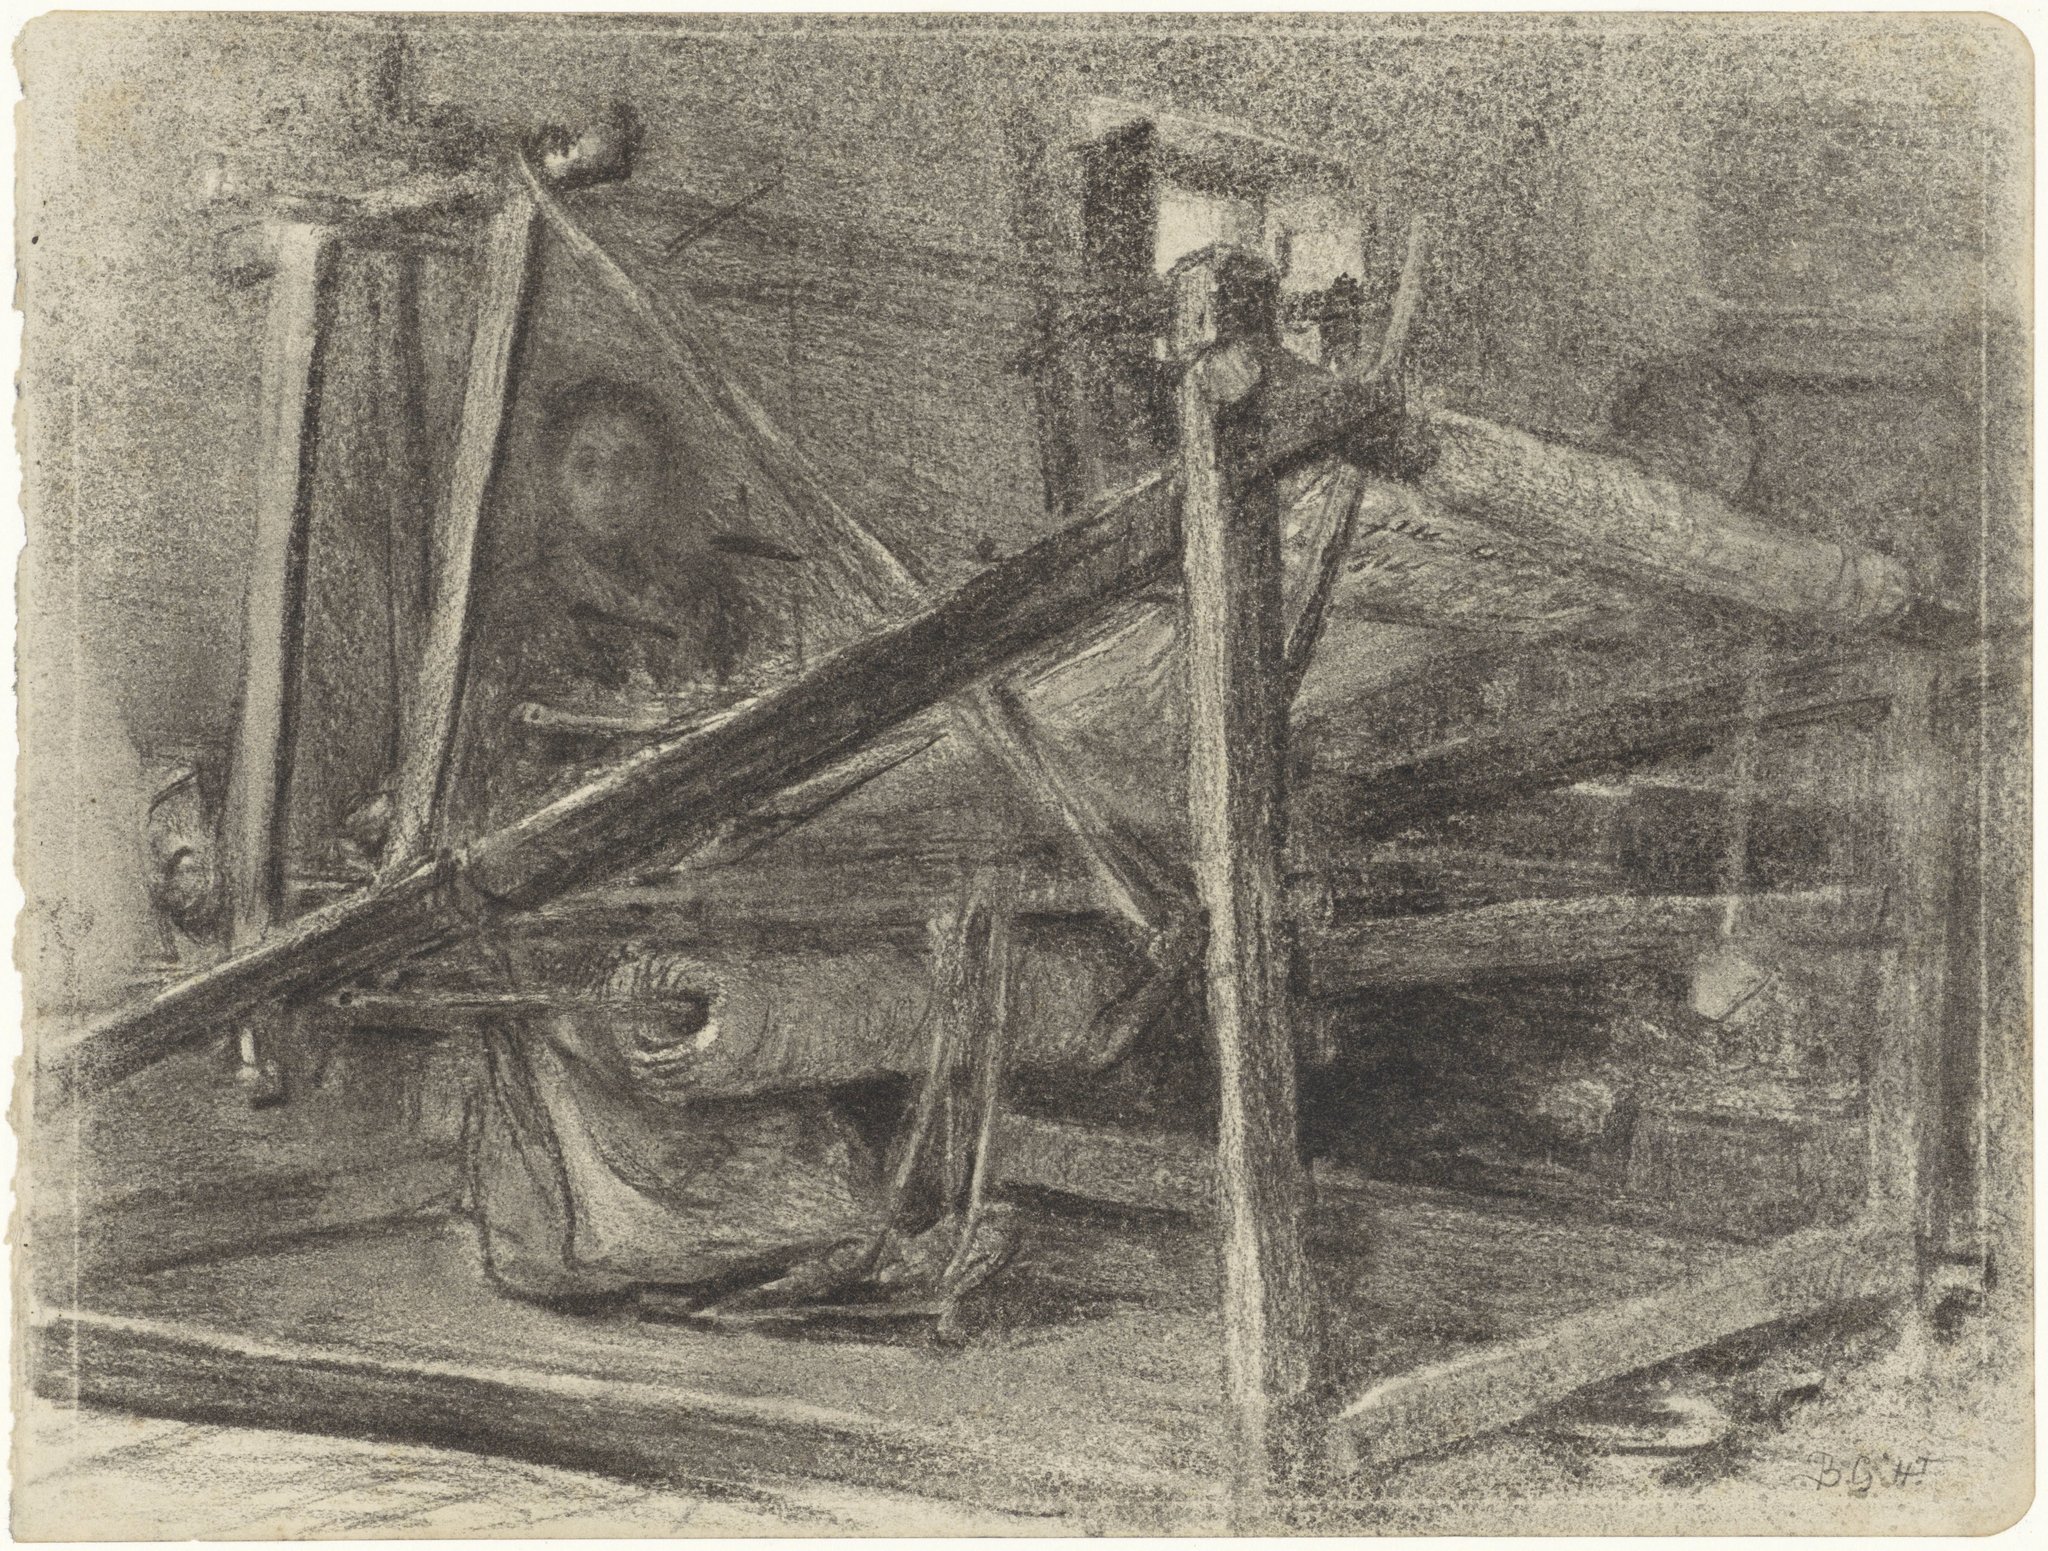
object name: drawing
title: Weeftoestel en een vrouw op de achtergrond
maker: a.a.l. de grammont-hubrecht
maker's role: draughtsman, painter, print maker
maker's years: 1855-1913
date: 1865-1913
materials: chalk, paper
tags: weaving-loom